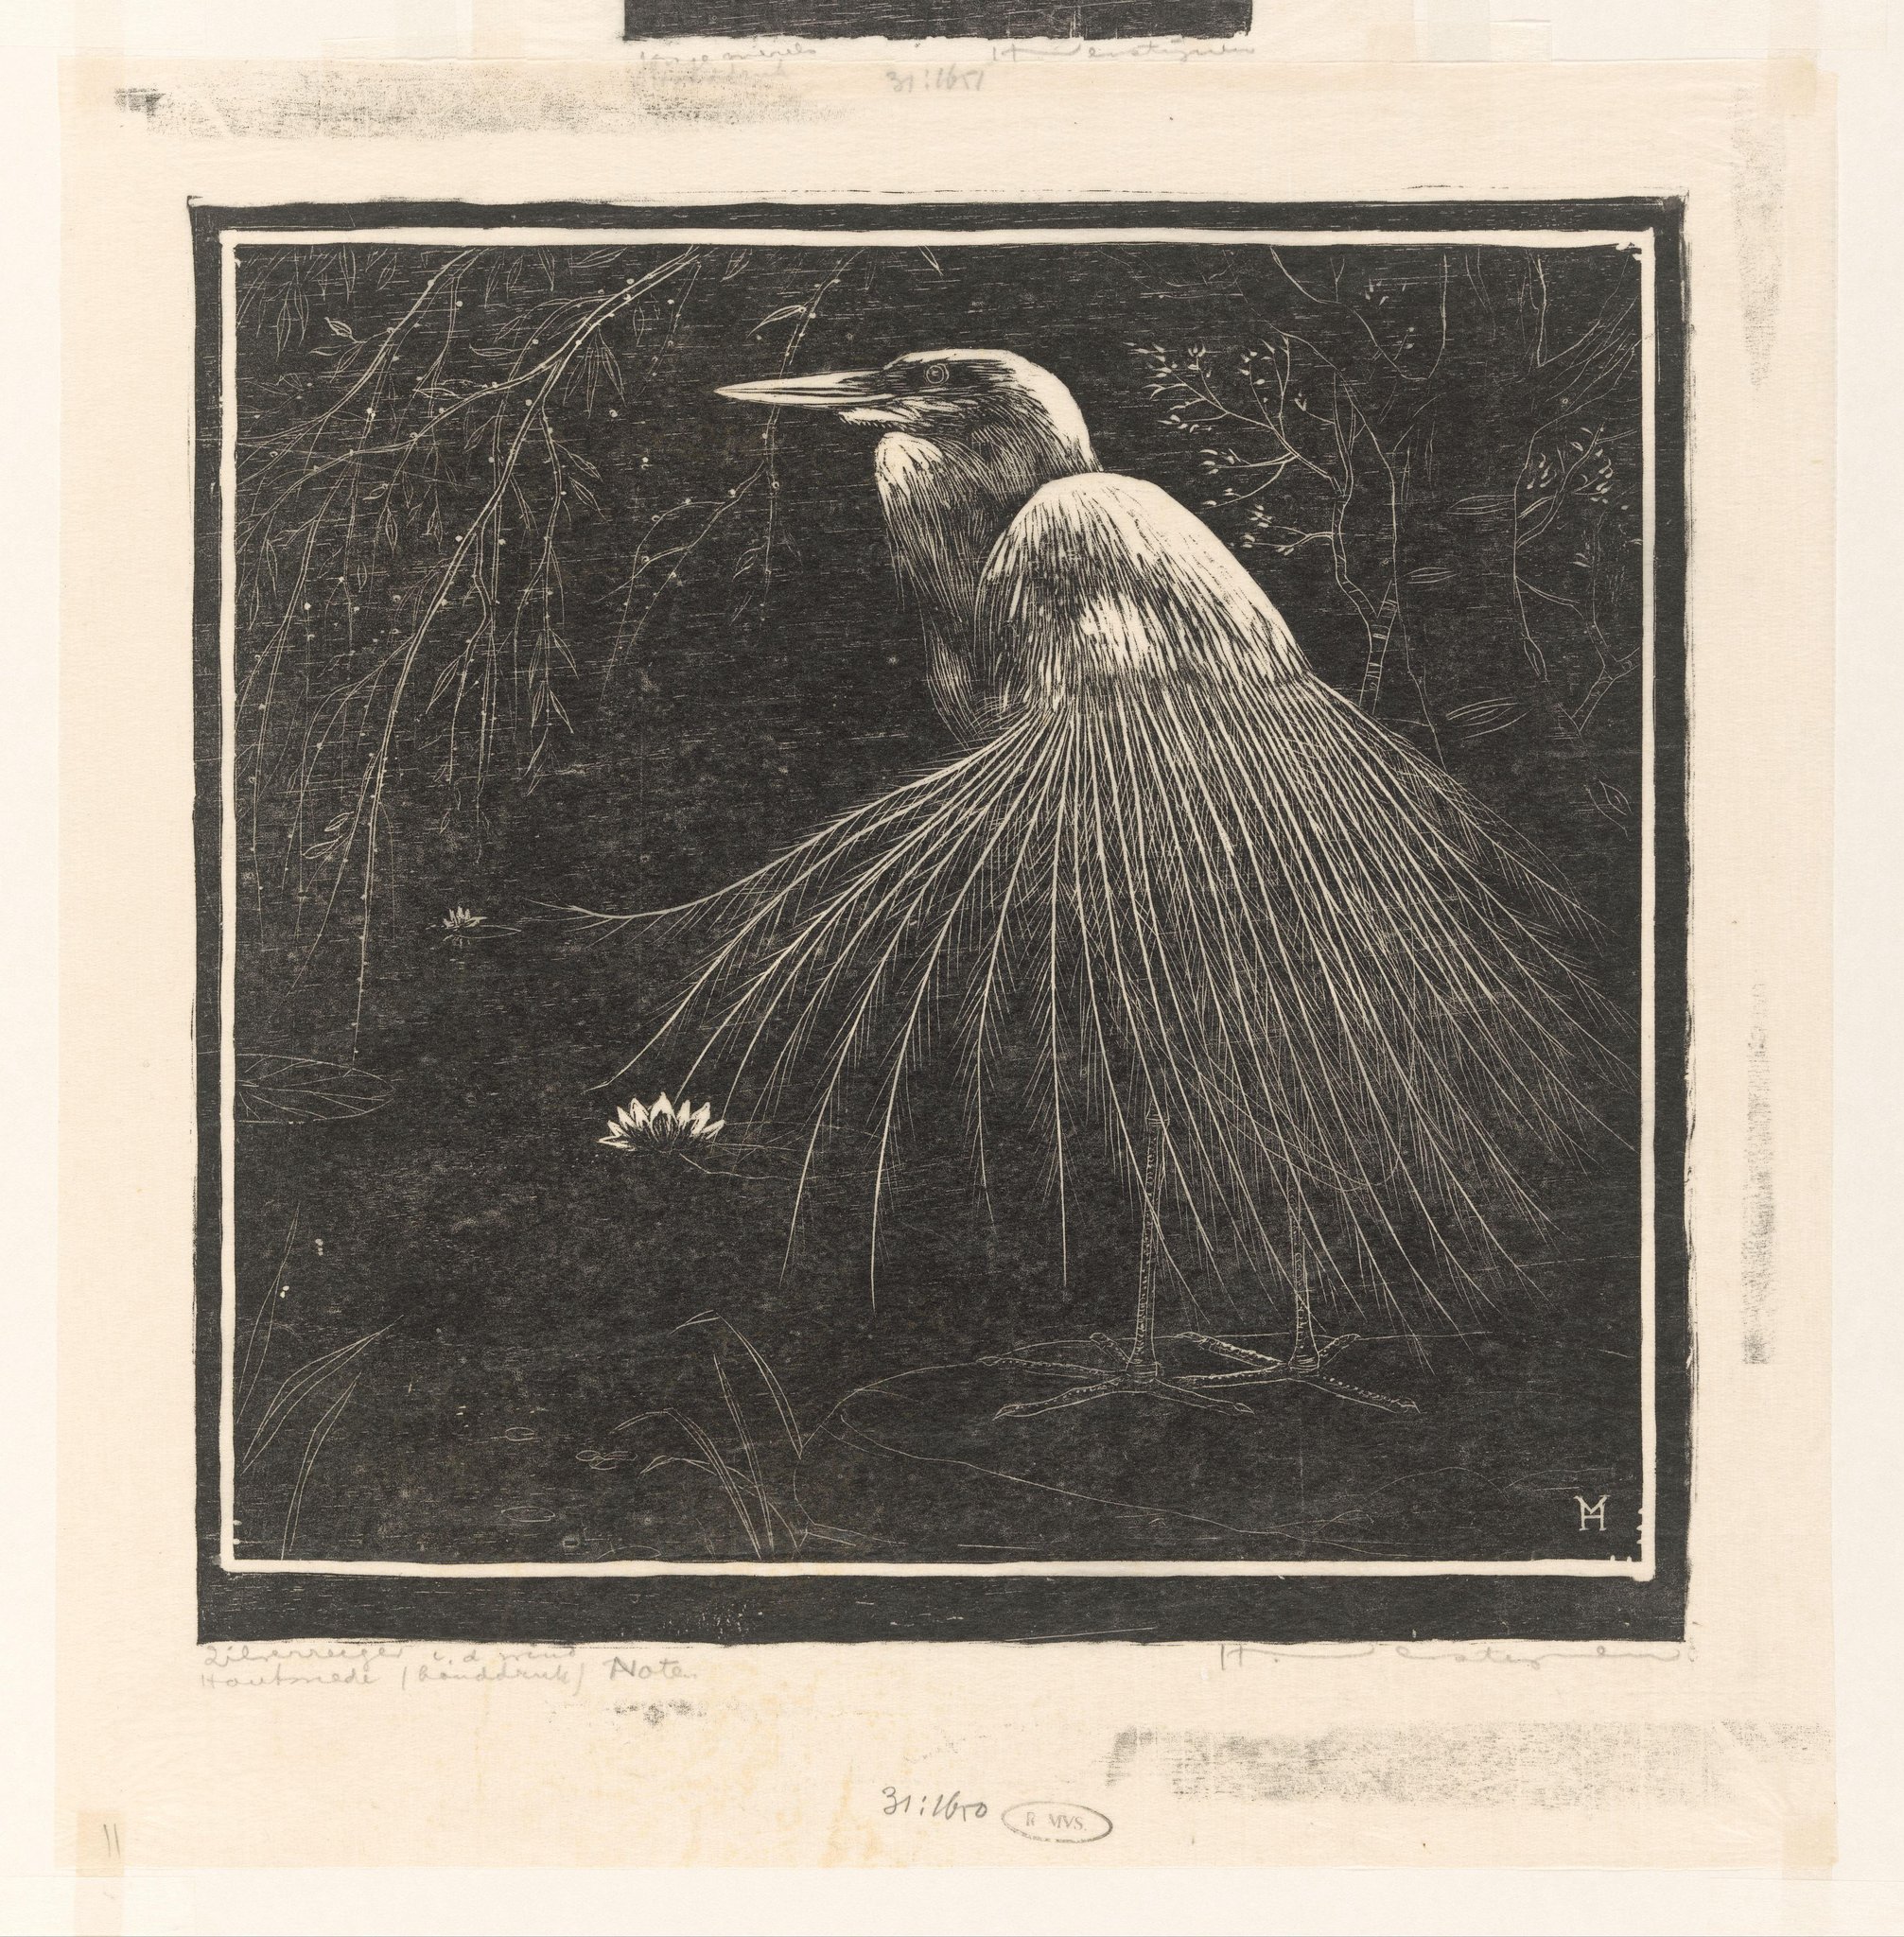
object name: print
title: Zilverreiger in de wind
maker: henri verstijnen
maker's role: draughtsman, print maker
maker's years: 1882-1940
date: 1892-1931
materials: paper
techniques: woodcut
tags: shore-birds and wading-birds: heron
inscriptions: collector's mark: Lugt 2228, annotation: ‘Noten’